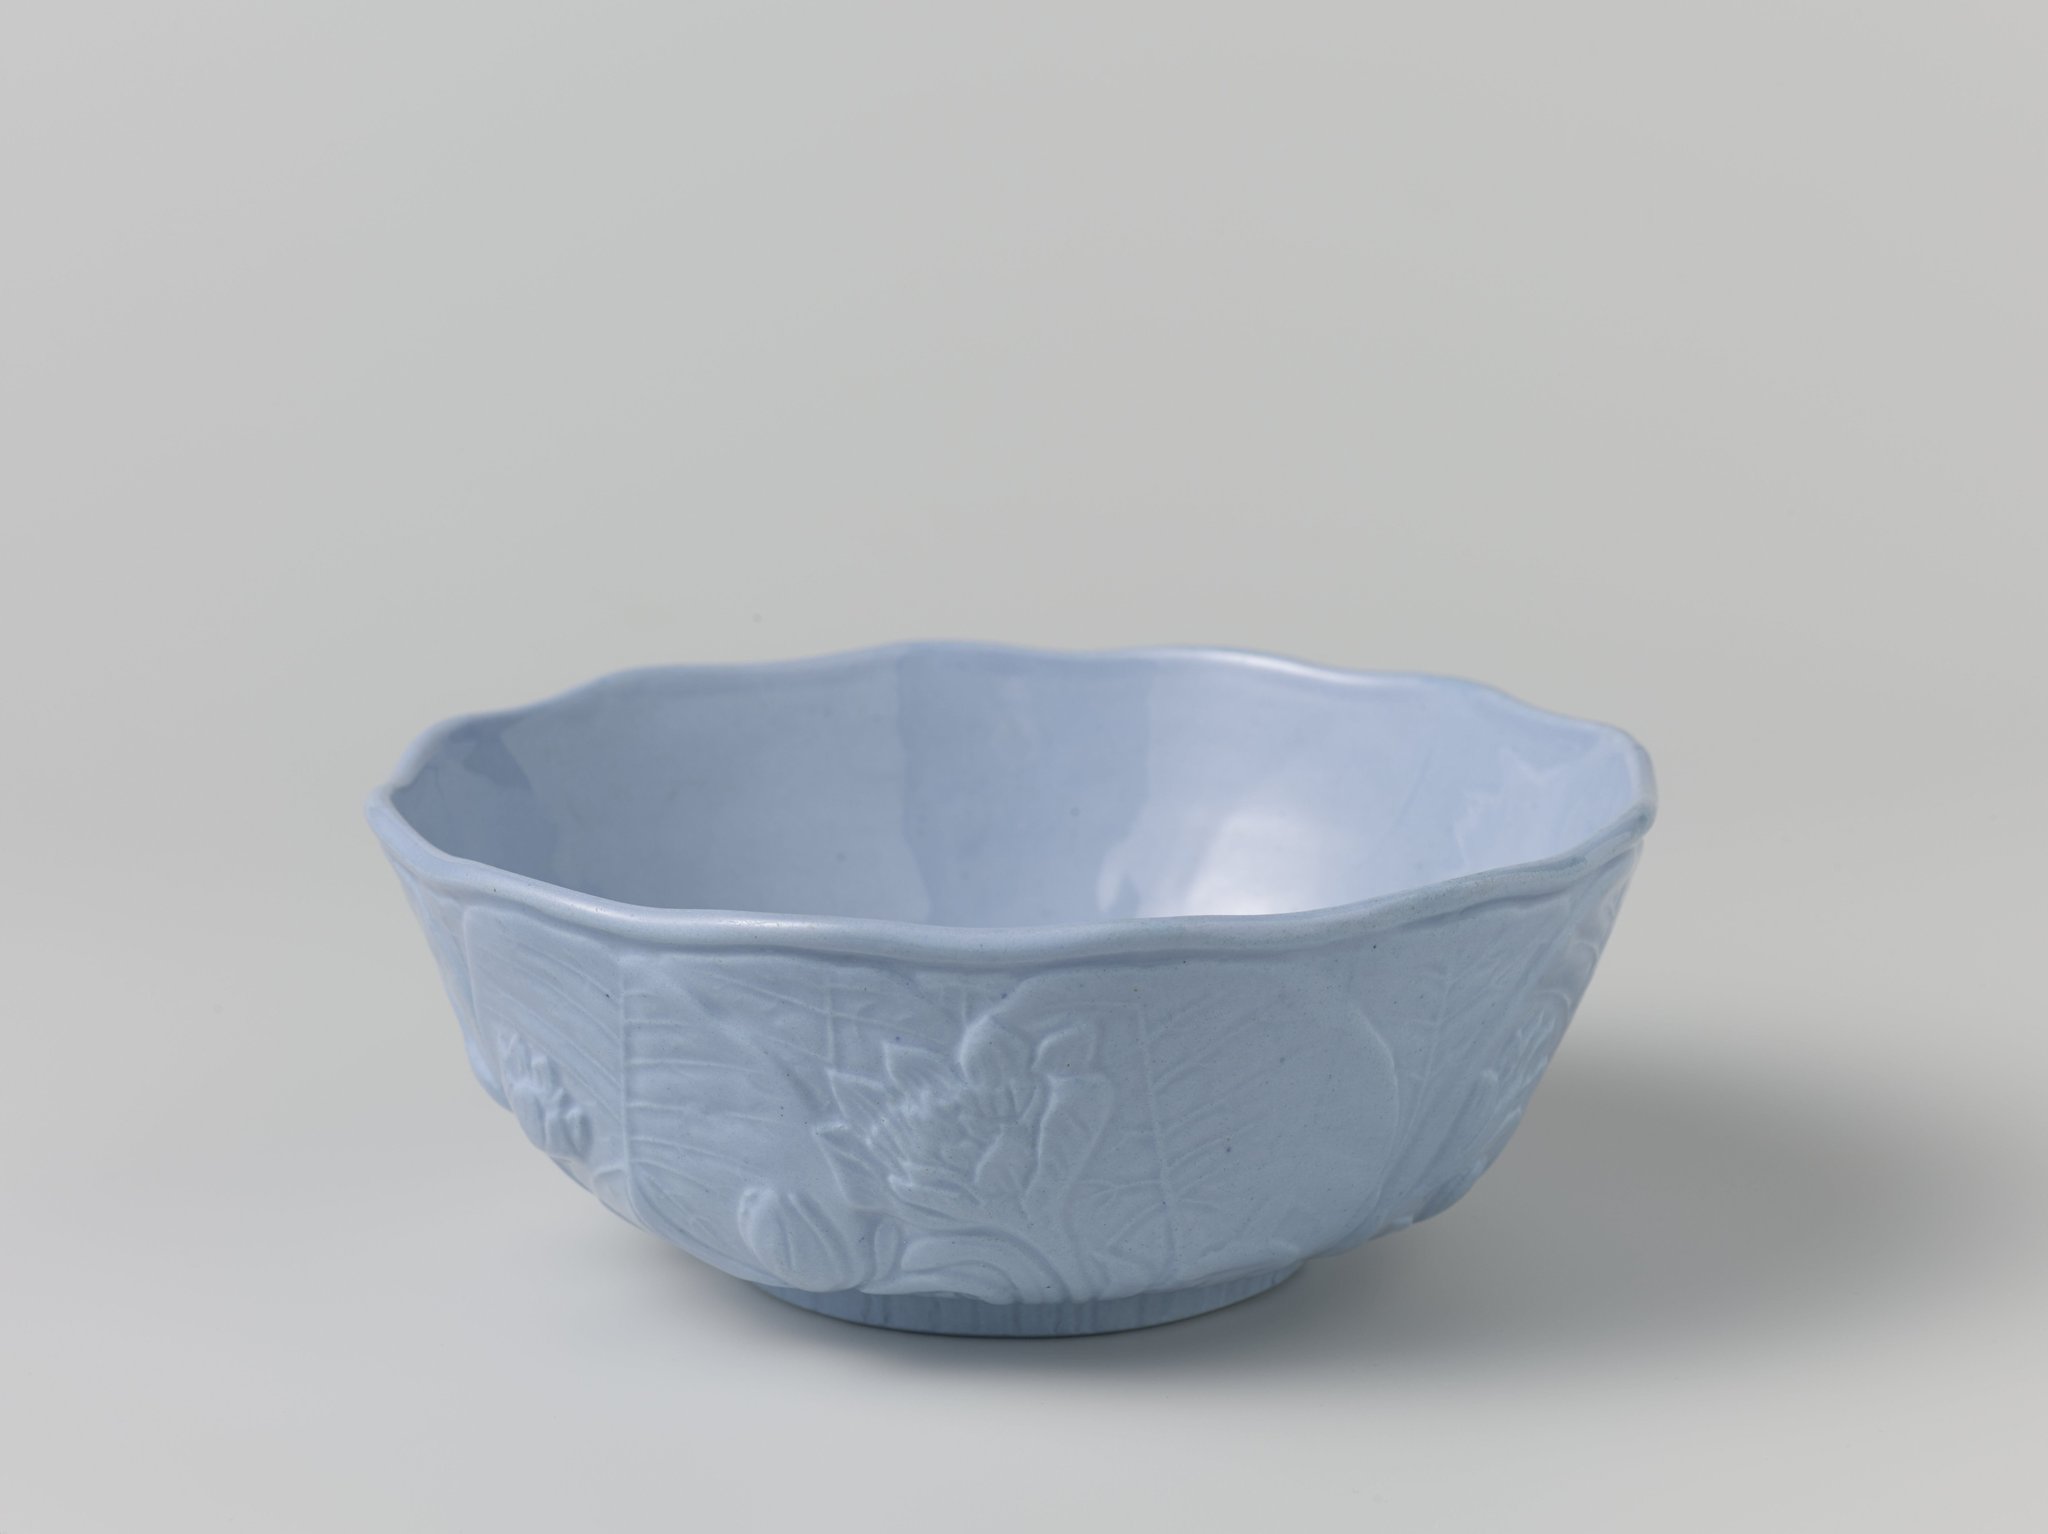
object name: bowl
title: Spoelkom, blauw, met bladeren en bloemen in reliëf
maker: petrus regout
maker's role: plateelbakker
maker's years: 1801-1879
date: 1801-1879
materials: earthenware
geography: maastricht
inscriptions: check stamp: ‘P. REGOUT // MAASTRICHT // 00’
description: Spoelkom van blauwsteen, met in reliëf bladeren en bloemen over het gehele oppervlak. De bovenrand van de kom is geschulpt.